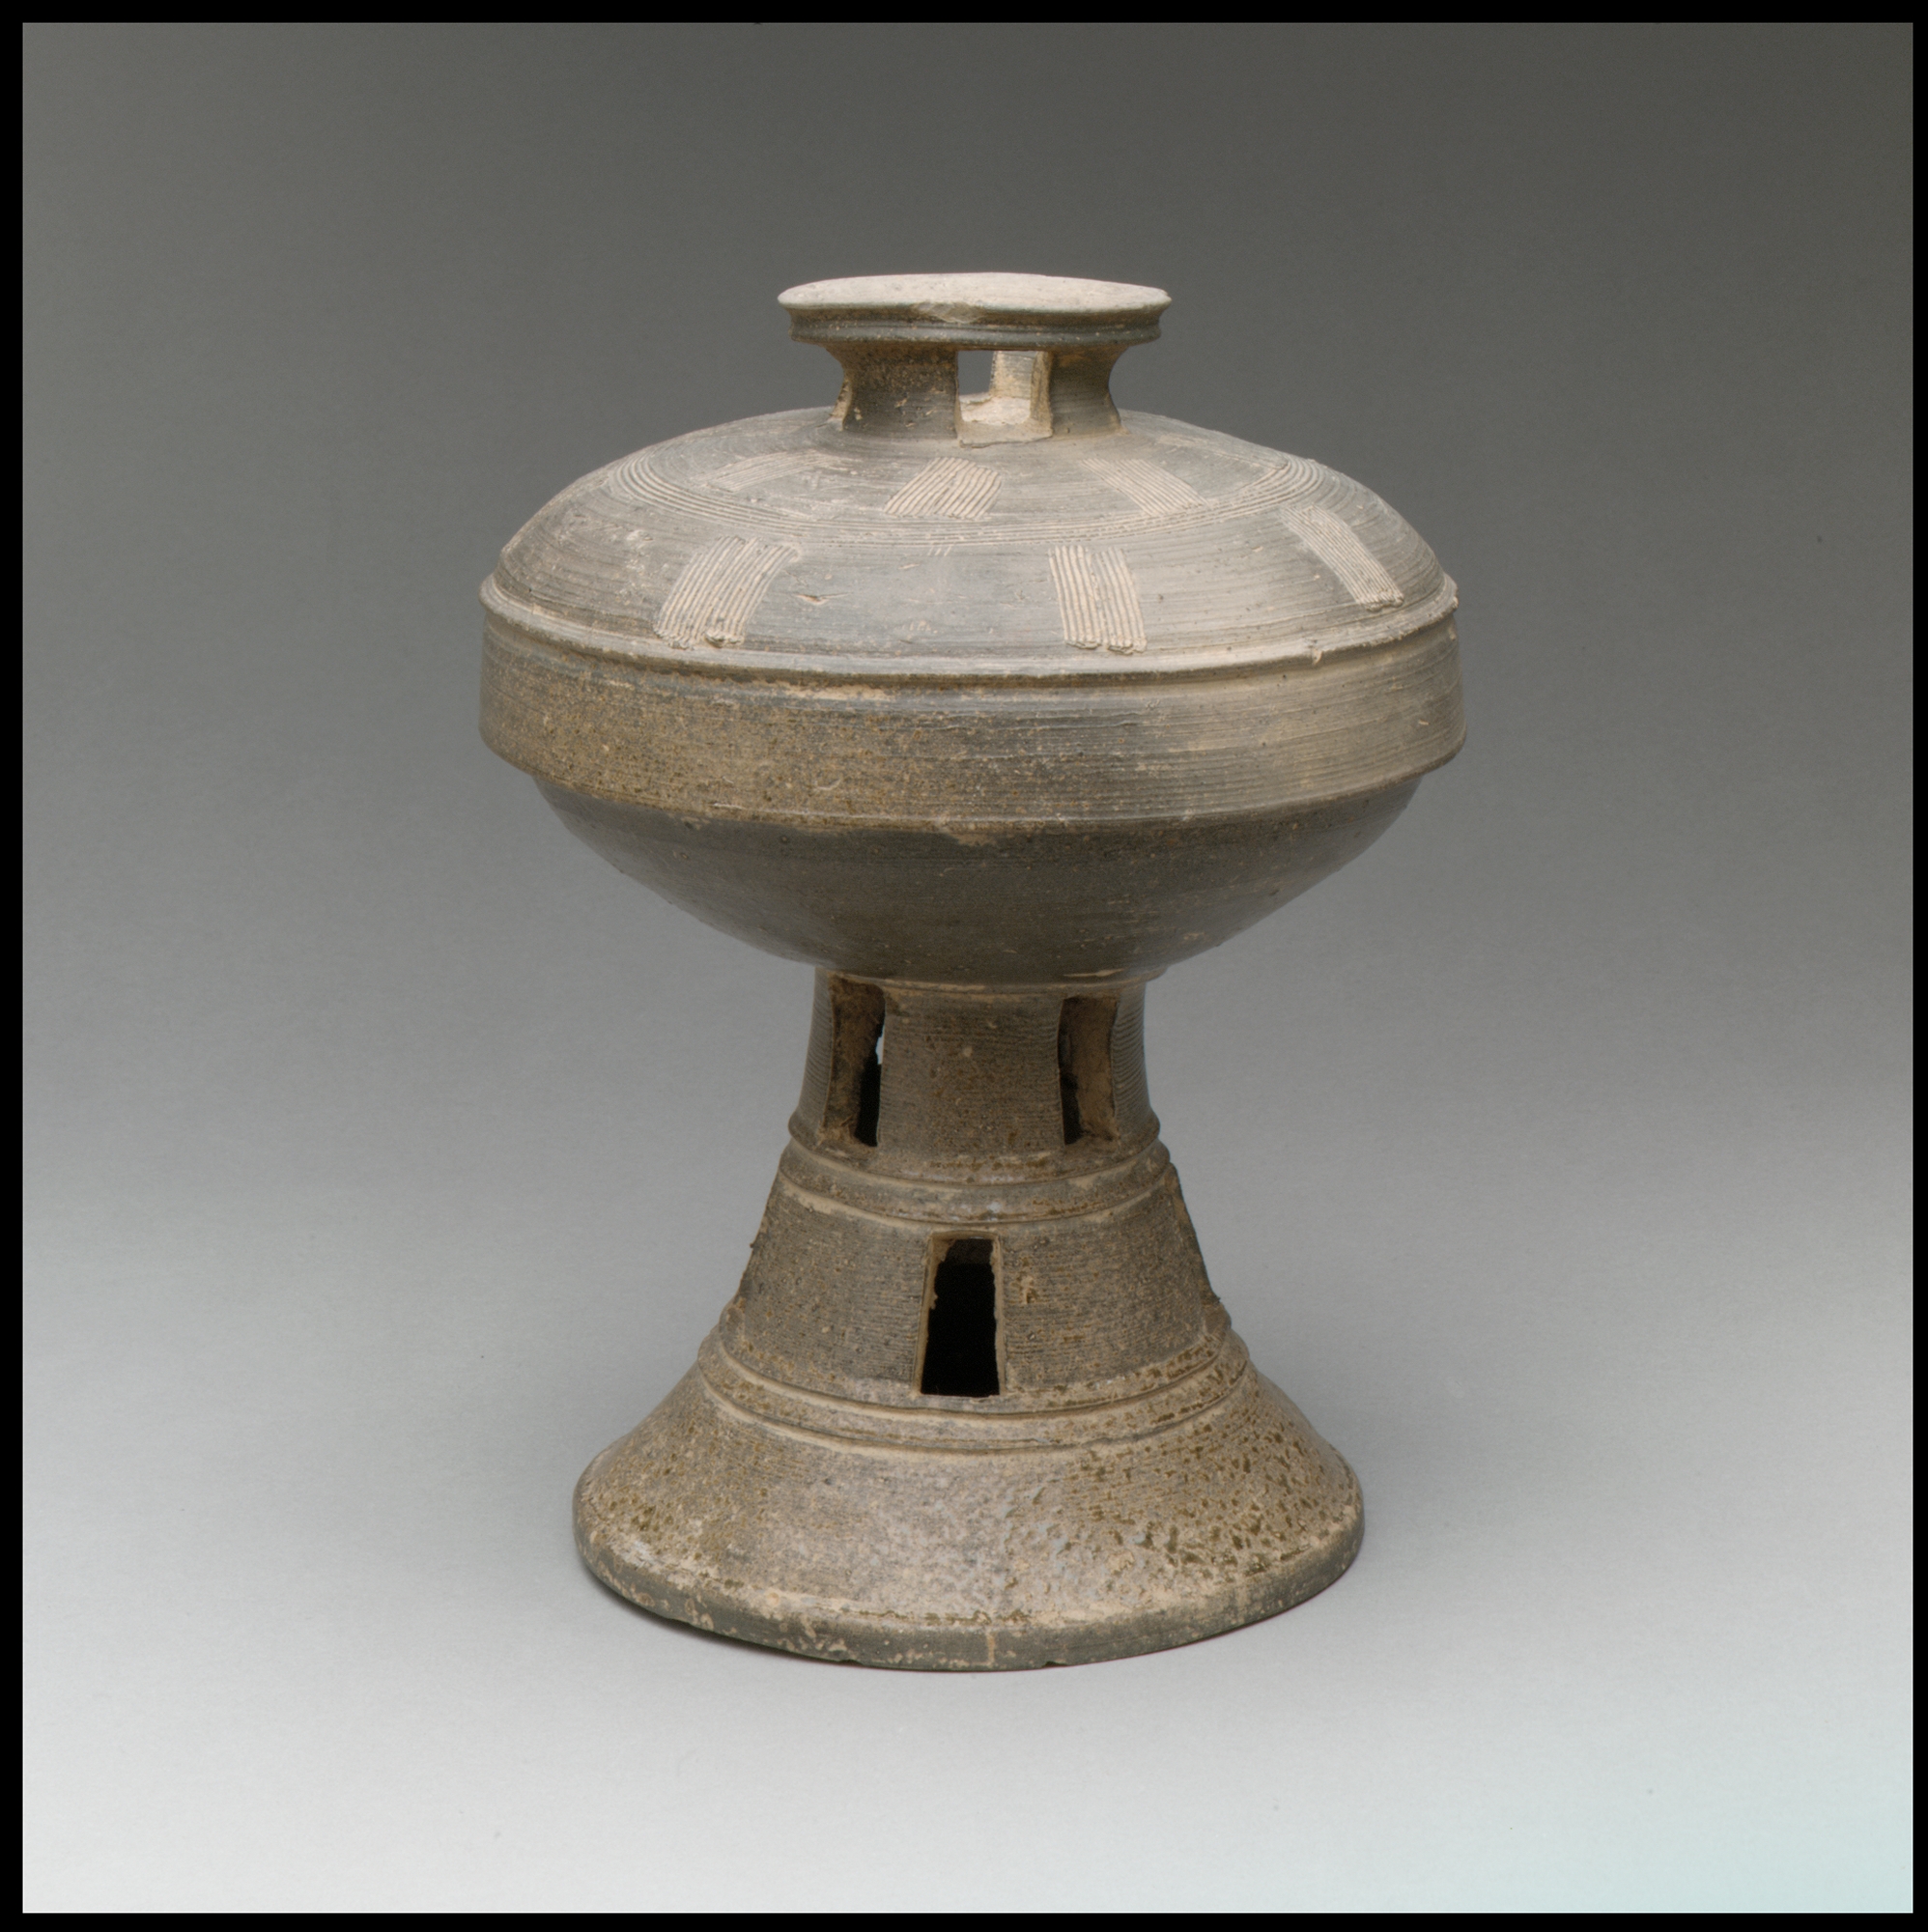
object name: pedestal dish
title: Pedestal dish with cover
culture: korean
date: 401-600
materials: wood, glaze, stoneware